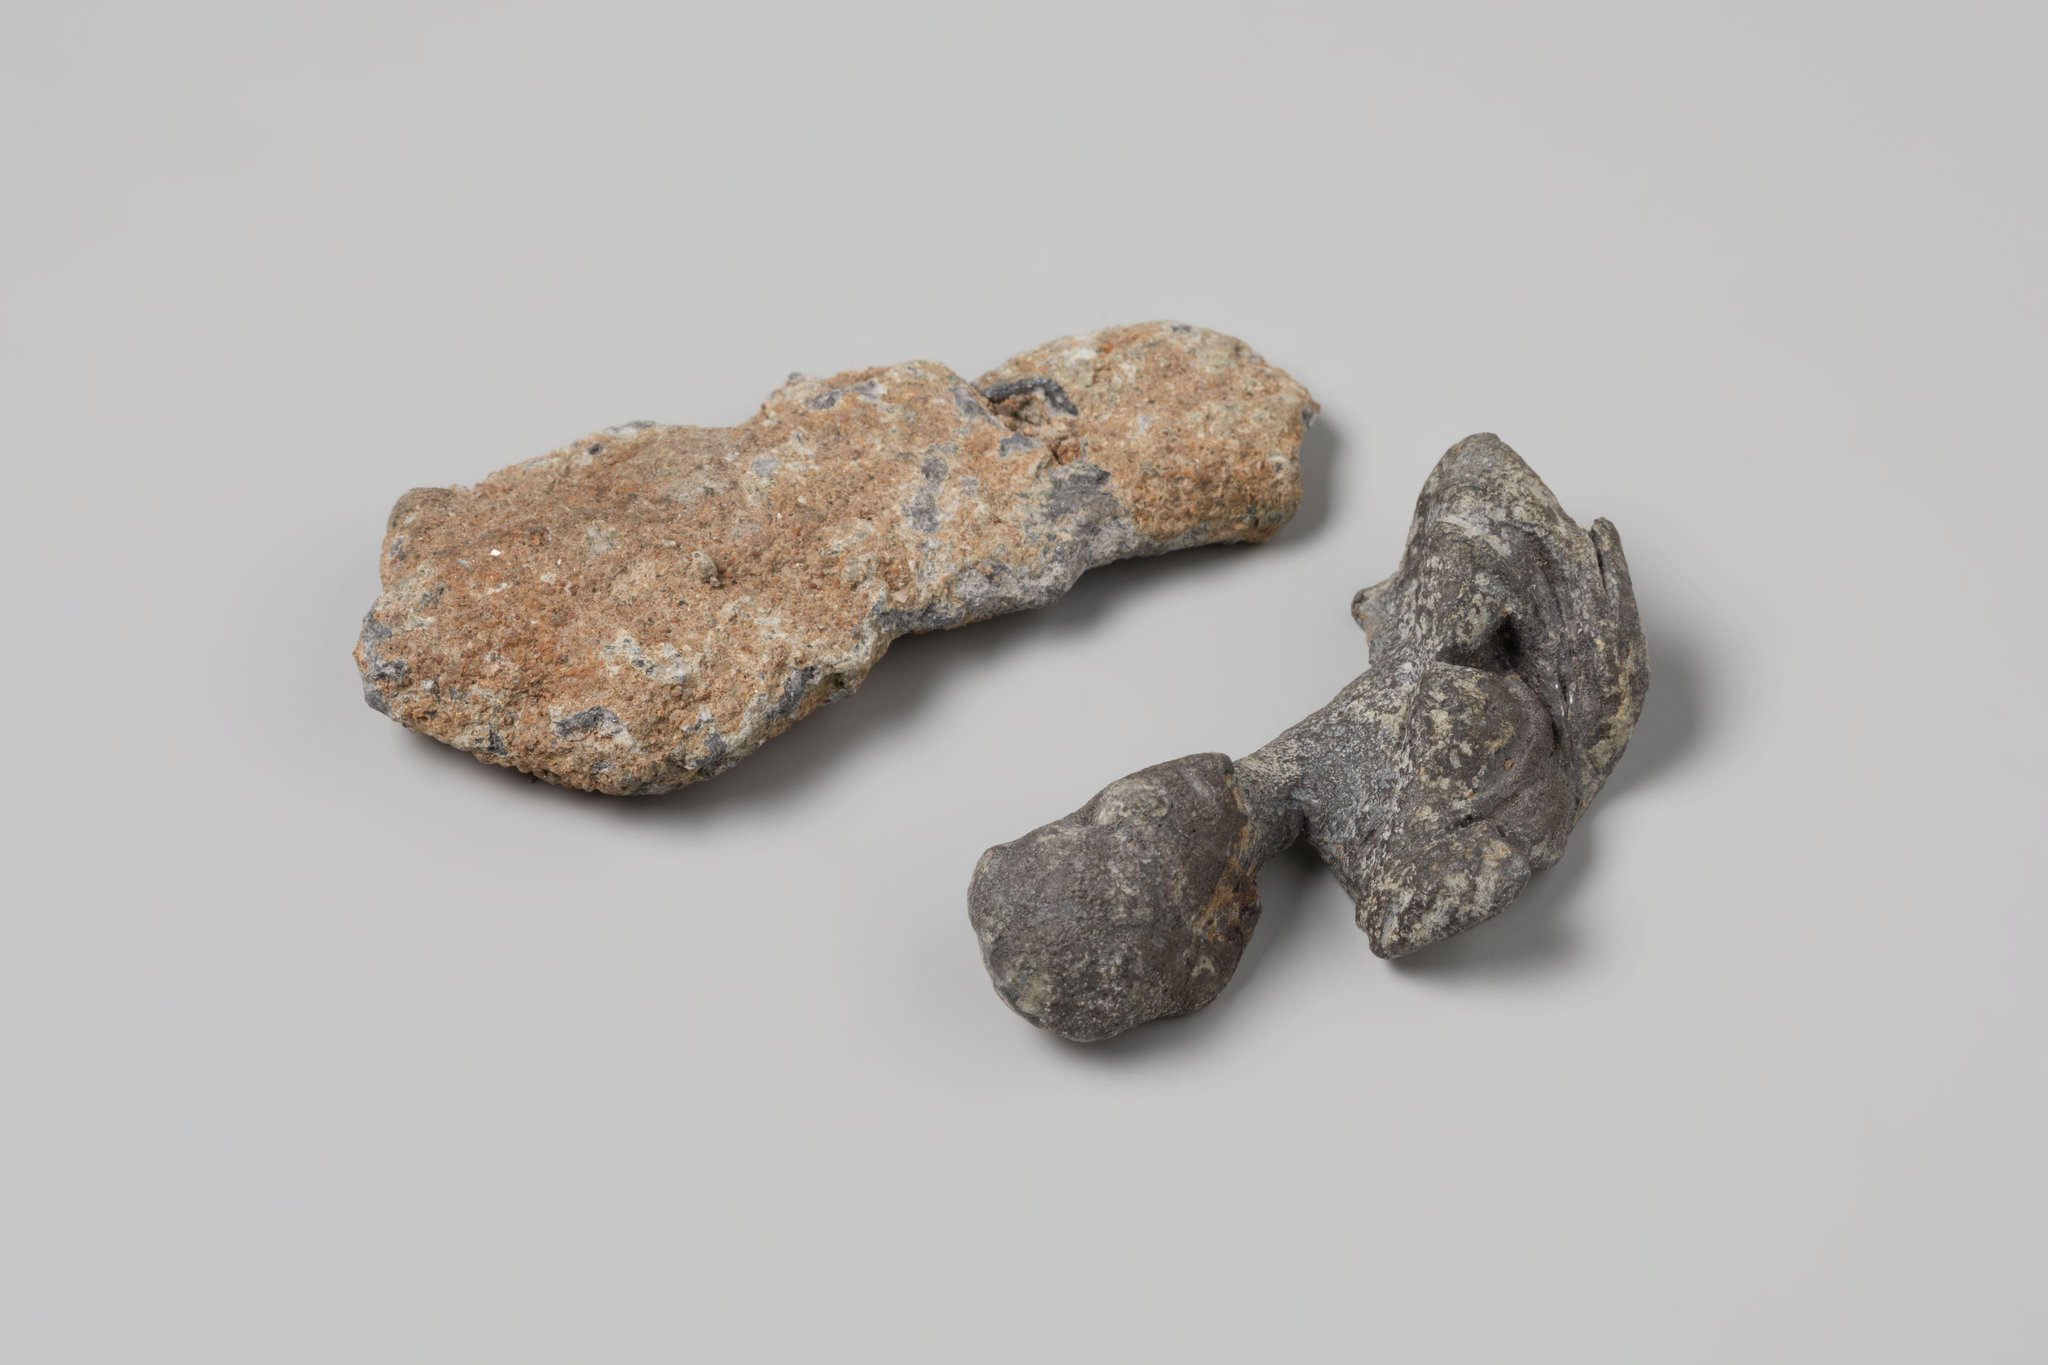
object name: beslag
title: Decoratief beslag uit het wrak van de Oost-Indiëvaarder Hollandia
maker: Anonymous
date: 1700-1743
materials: lead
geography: netherlands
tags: verenigde oostindische compagnie, hollandia (schip), annet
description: Fitting, decorative fitting or fragment; fragm, id. NG 1980-27H1051, squashed, eroded.